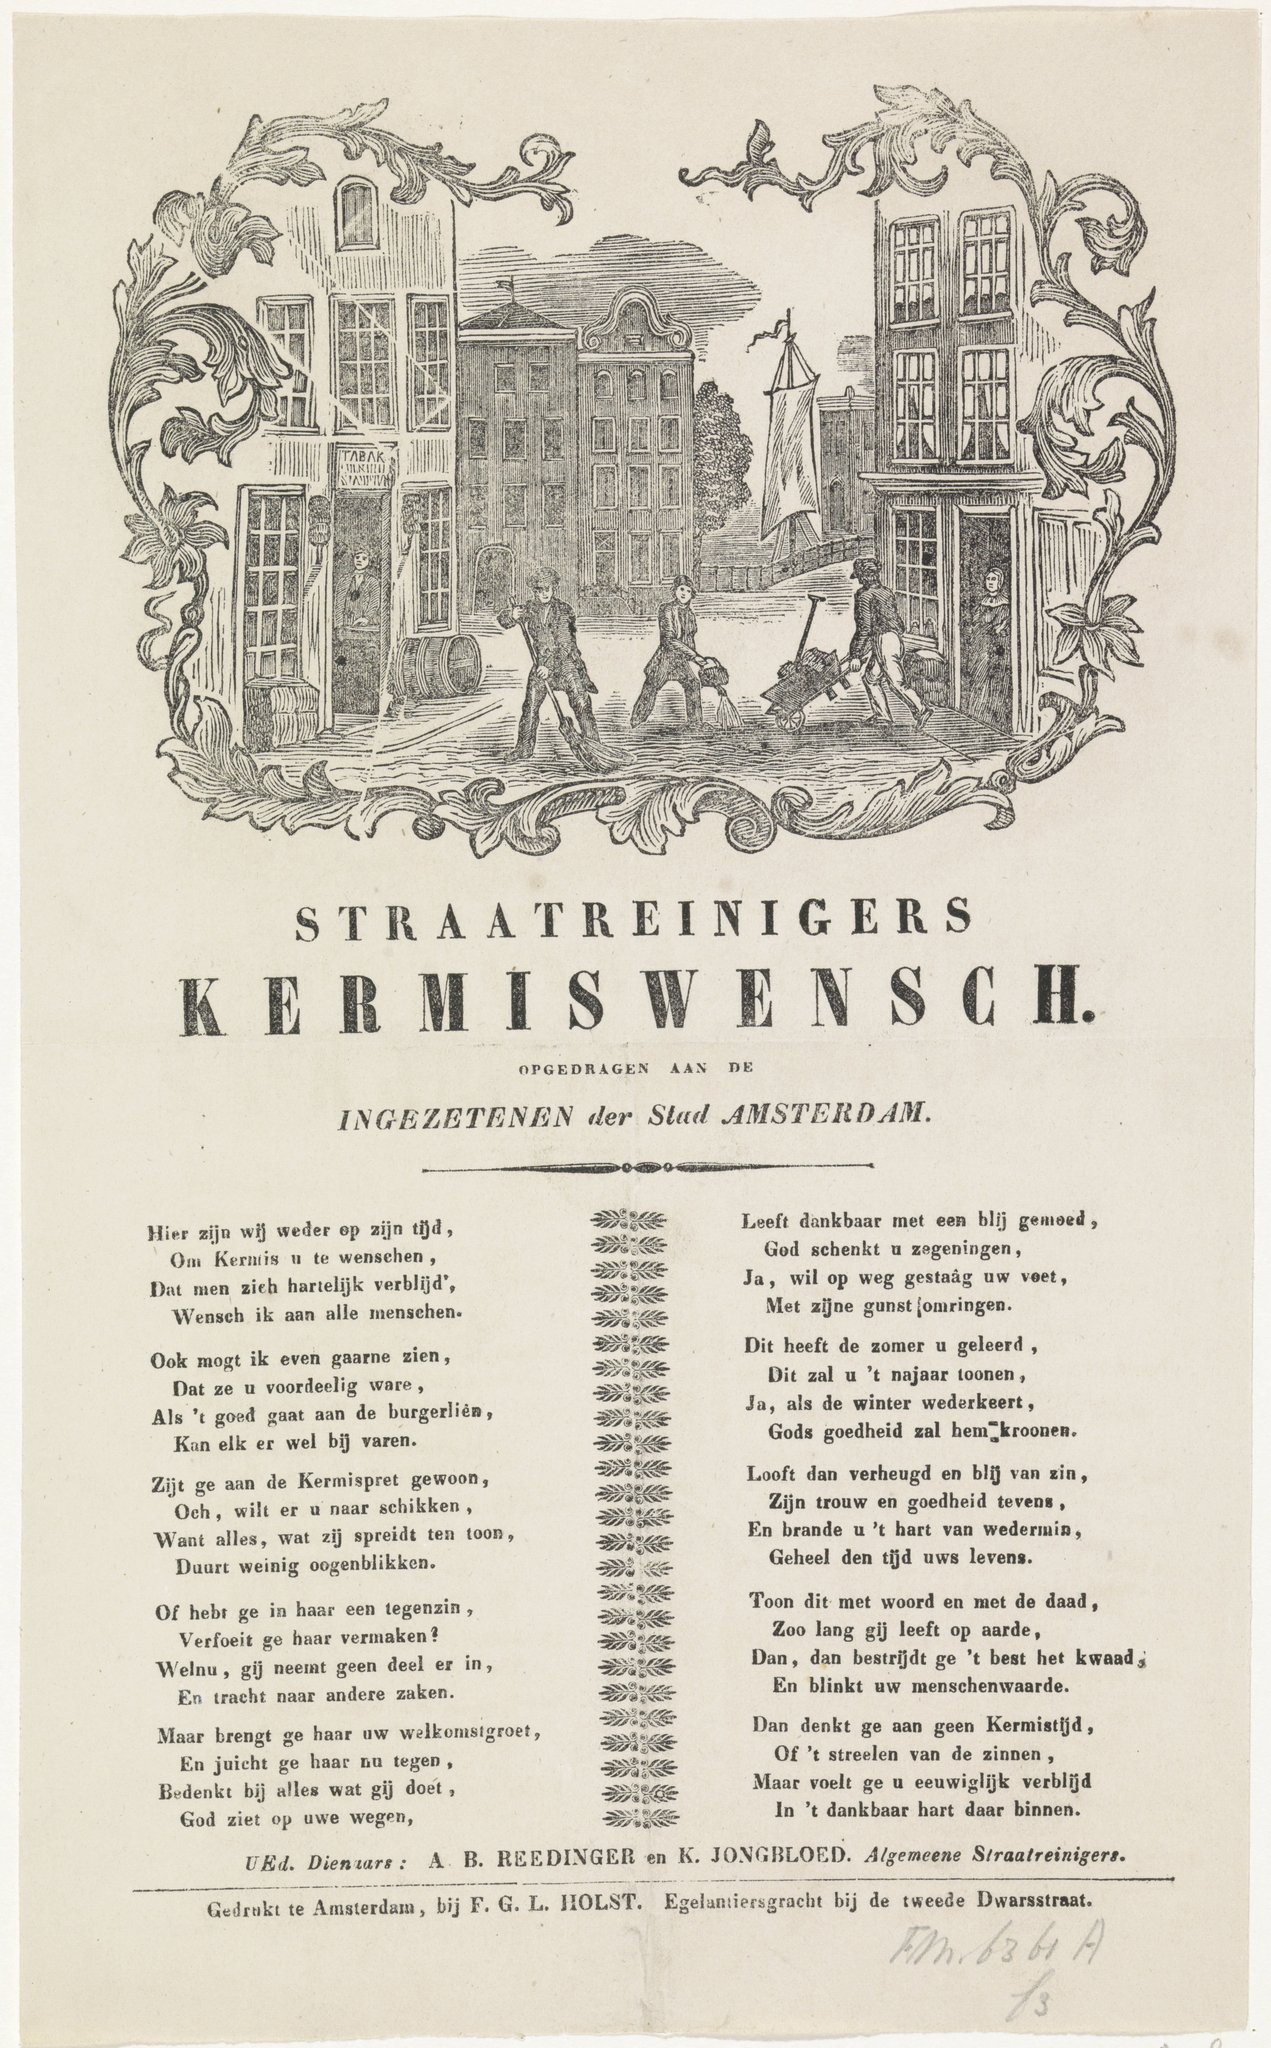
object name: print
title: Straatreinigers Kermiswensch. Opgedragen aan de Ingezetenen der Stad Amsterdam.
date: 1855-1861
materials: paper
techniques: letterpress printing, engraving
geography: amsterdam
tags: street - ii - ideal city, street sweeping, street sweeper, amsterdam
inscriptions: collector's mark: Lugt 2228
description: Kermisprent van de Amsterdamse straatvegers, ca. 1855-1861. Gezicht in een straat te Amsterdam, waar twee straatvegers aan het werk zijn. Met een vers in twee kolommen. Namens de straatvegers: A.B. Reedinger en K. Jongbloed.